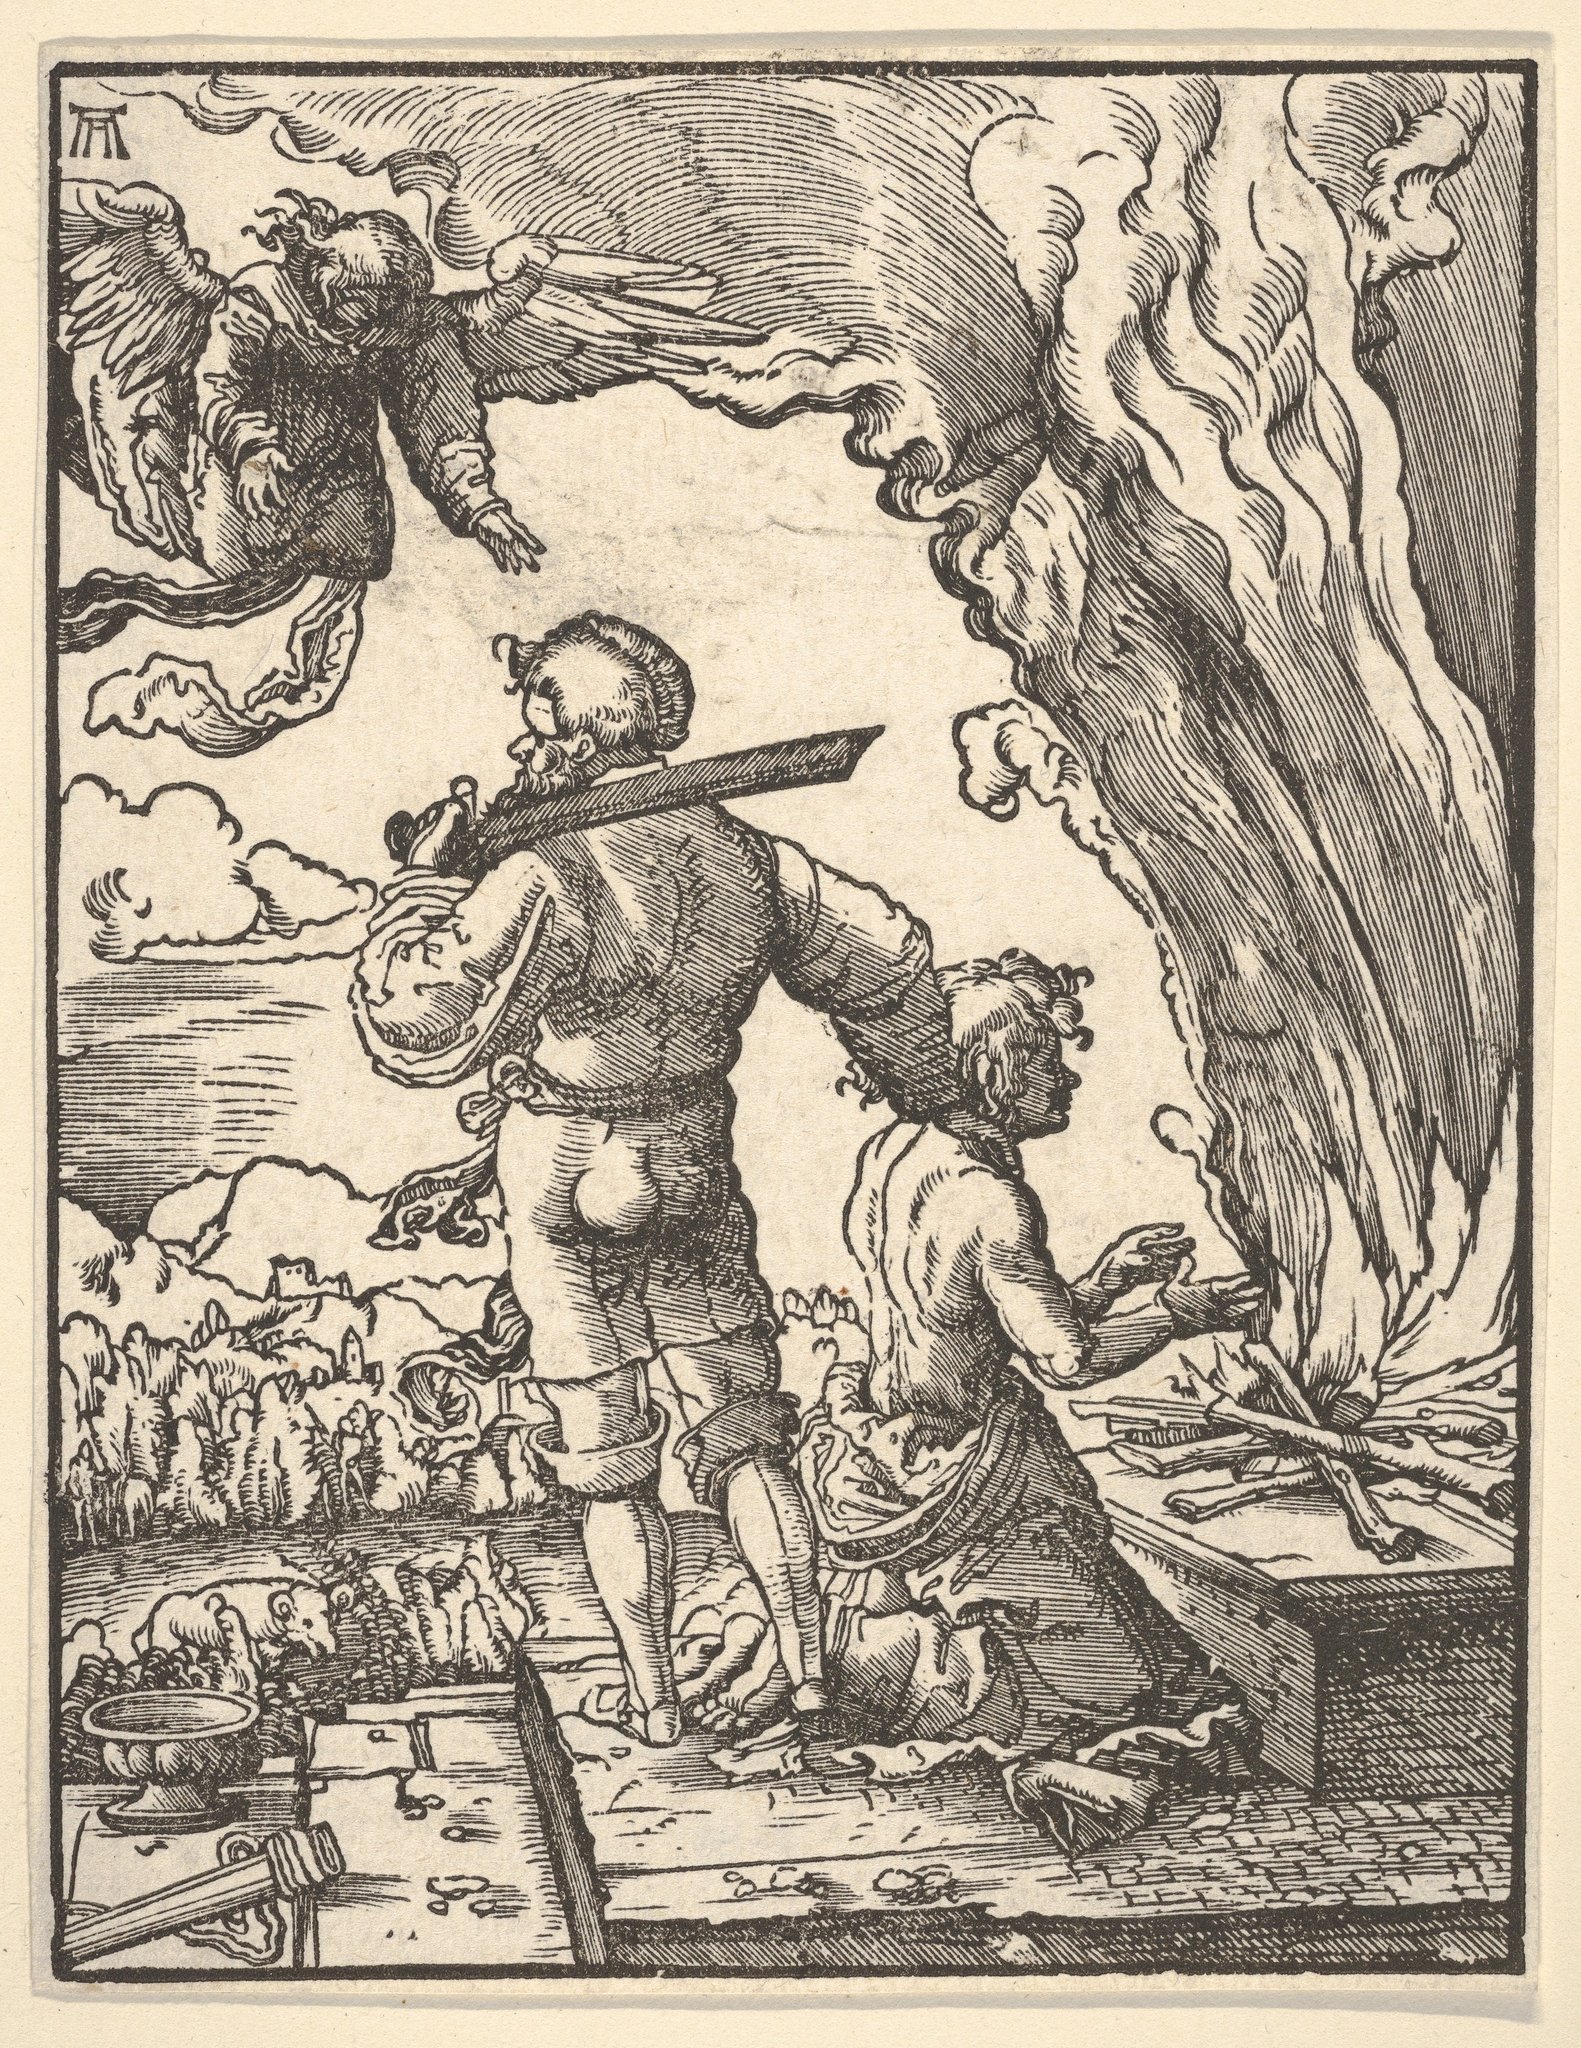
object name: print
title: Abraham's Sacrifice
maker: albrecht altdorfer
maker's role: artist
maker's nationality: german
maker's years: 1480-1538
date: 1480-1538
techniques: woodcut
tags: men,angels,abraham